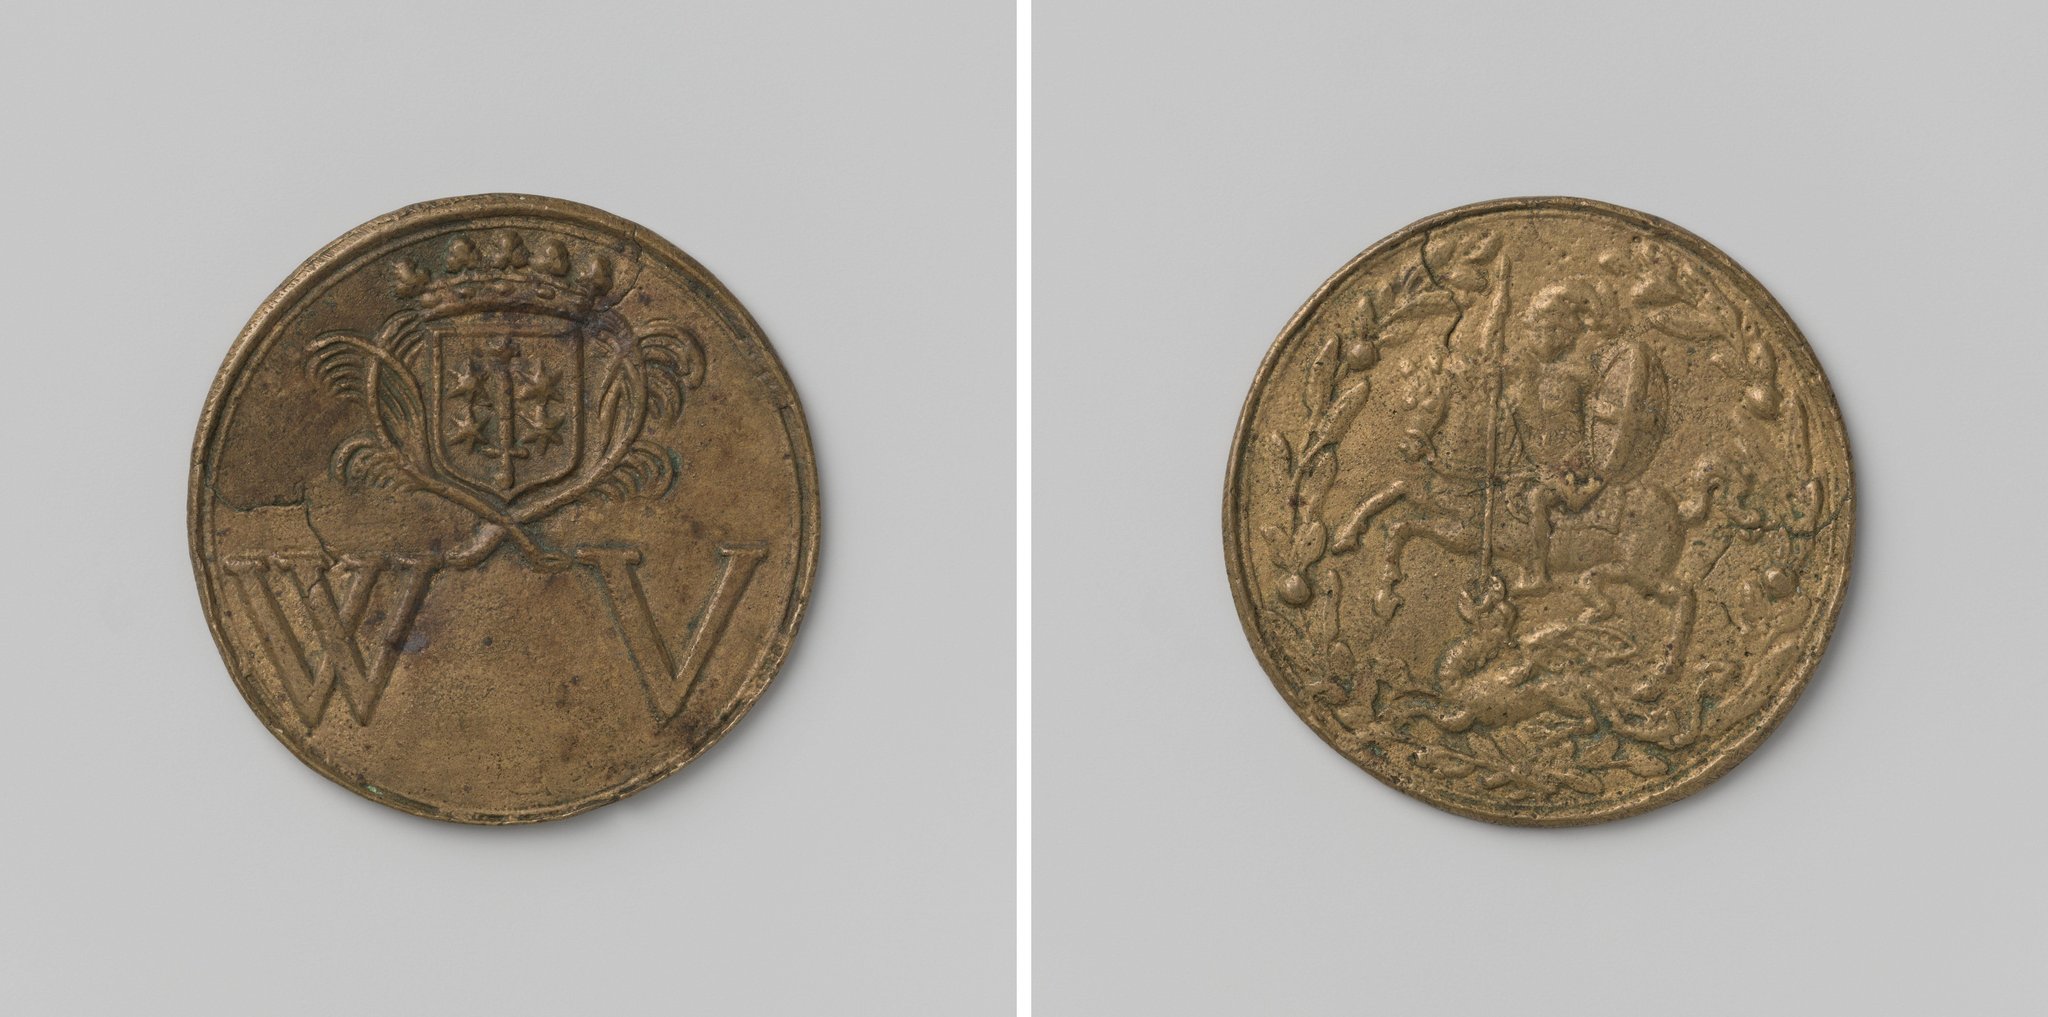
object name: marksman medal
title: Schutterij van Haarlem, schutterspenning van het Witte Vaandel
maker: Anonymous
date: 1650-1700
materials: brass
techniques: casting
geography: haarlem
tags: haarlem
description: Messing penning. Voorzijde: gekroond wapenschild op twee gekruiste palmtakken boven letters W en V. Keerzijde: gehelmde St. Joris te paard met schild in linkerhand doodt met speer ter aarde liggende draak